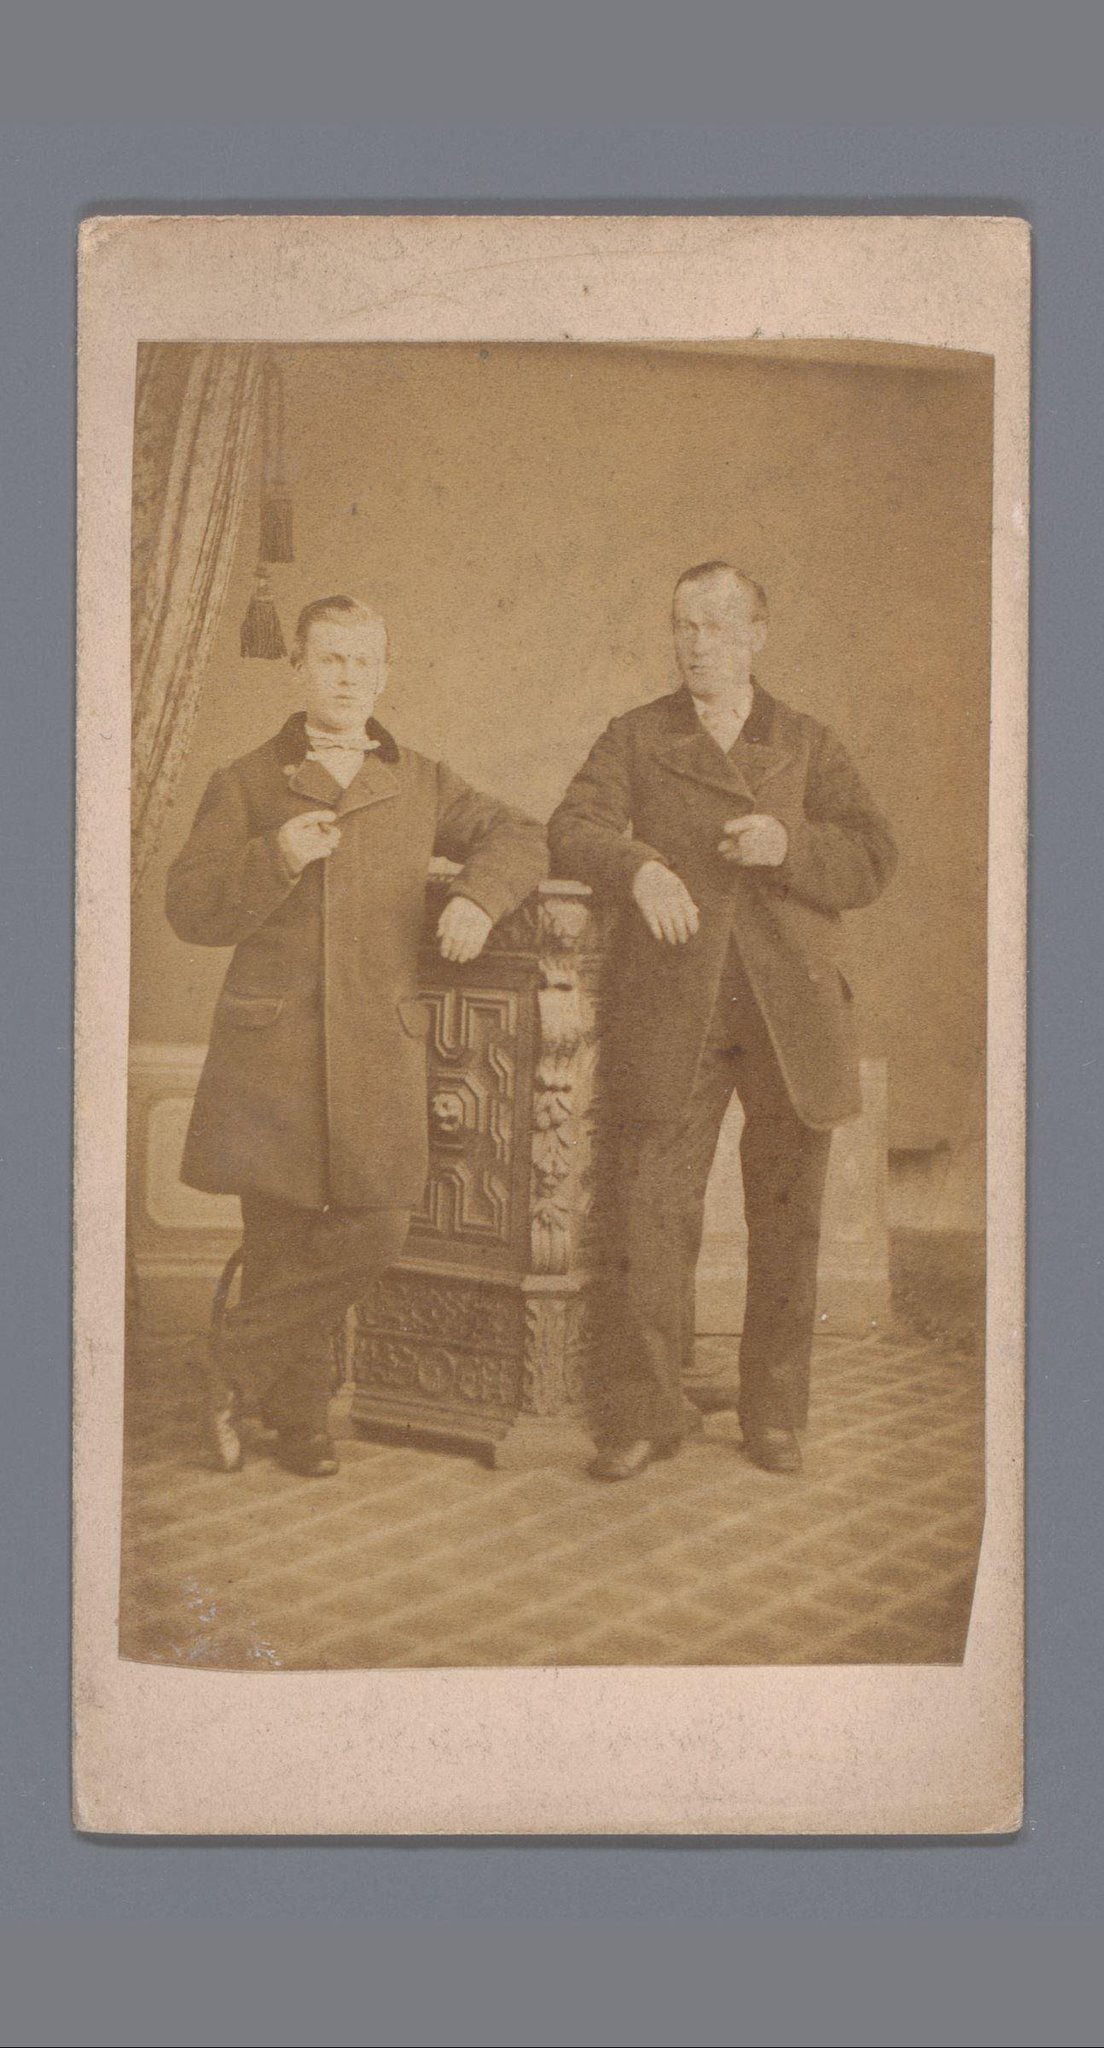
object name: carte de visite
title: Portret van twee onbekende mannen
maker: françois piron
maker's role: fotograaf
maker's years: 1835-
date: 1874-1880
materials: cardboard, paper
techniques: albumen print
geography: antwerp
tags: adult man, anonymous historical person portrayed, antwerp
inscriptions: inscription: ‘F. Piron/ Photographe/ Coin de la rue de la Bague 2/ près de la rue large des Bateliers/ Anvers.’